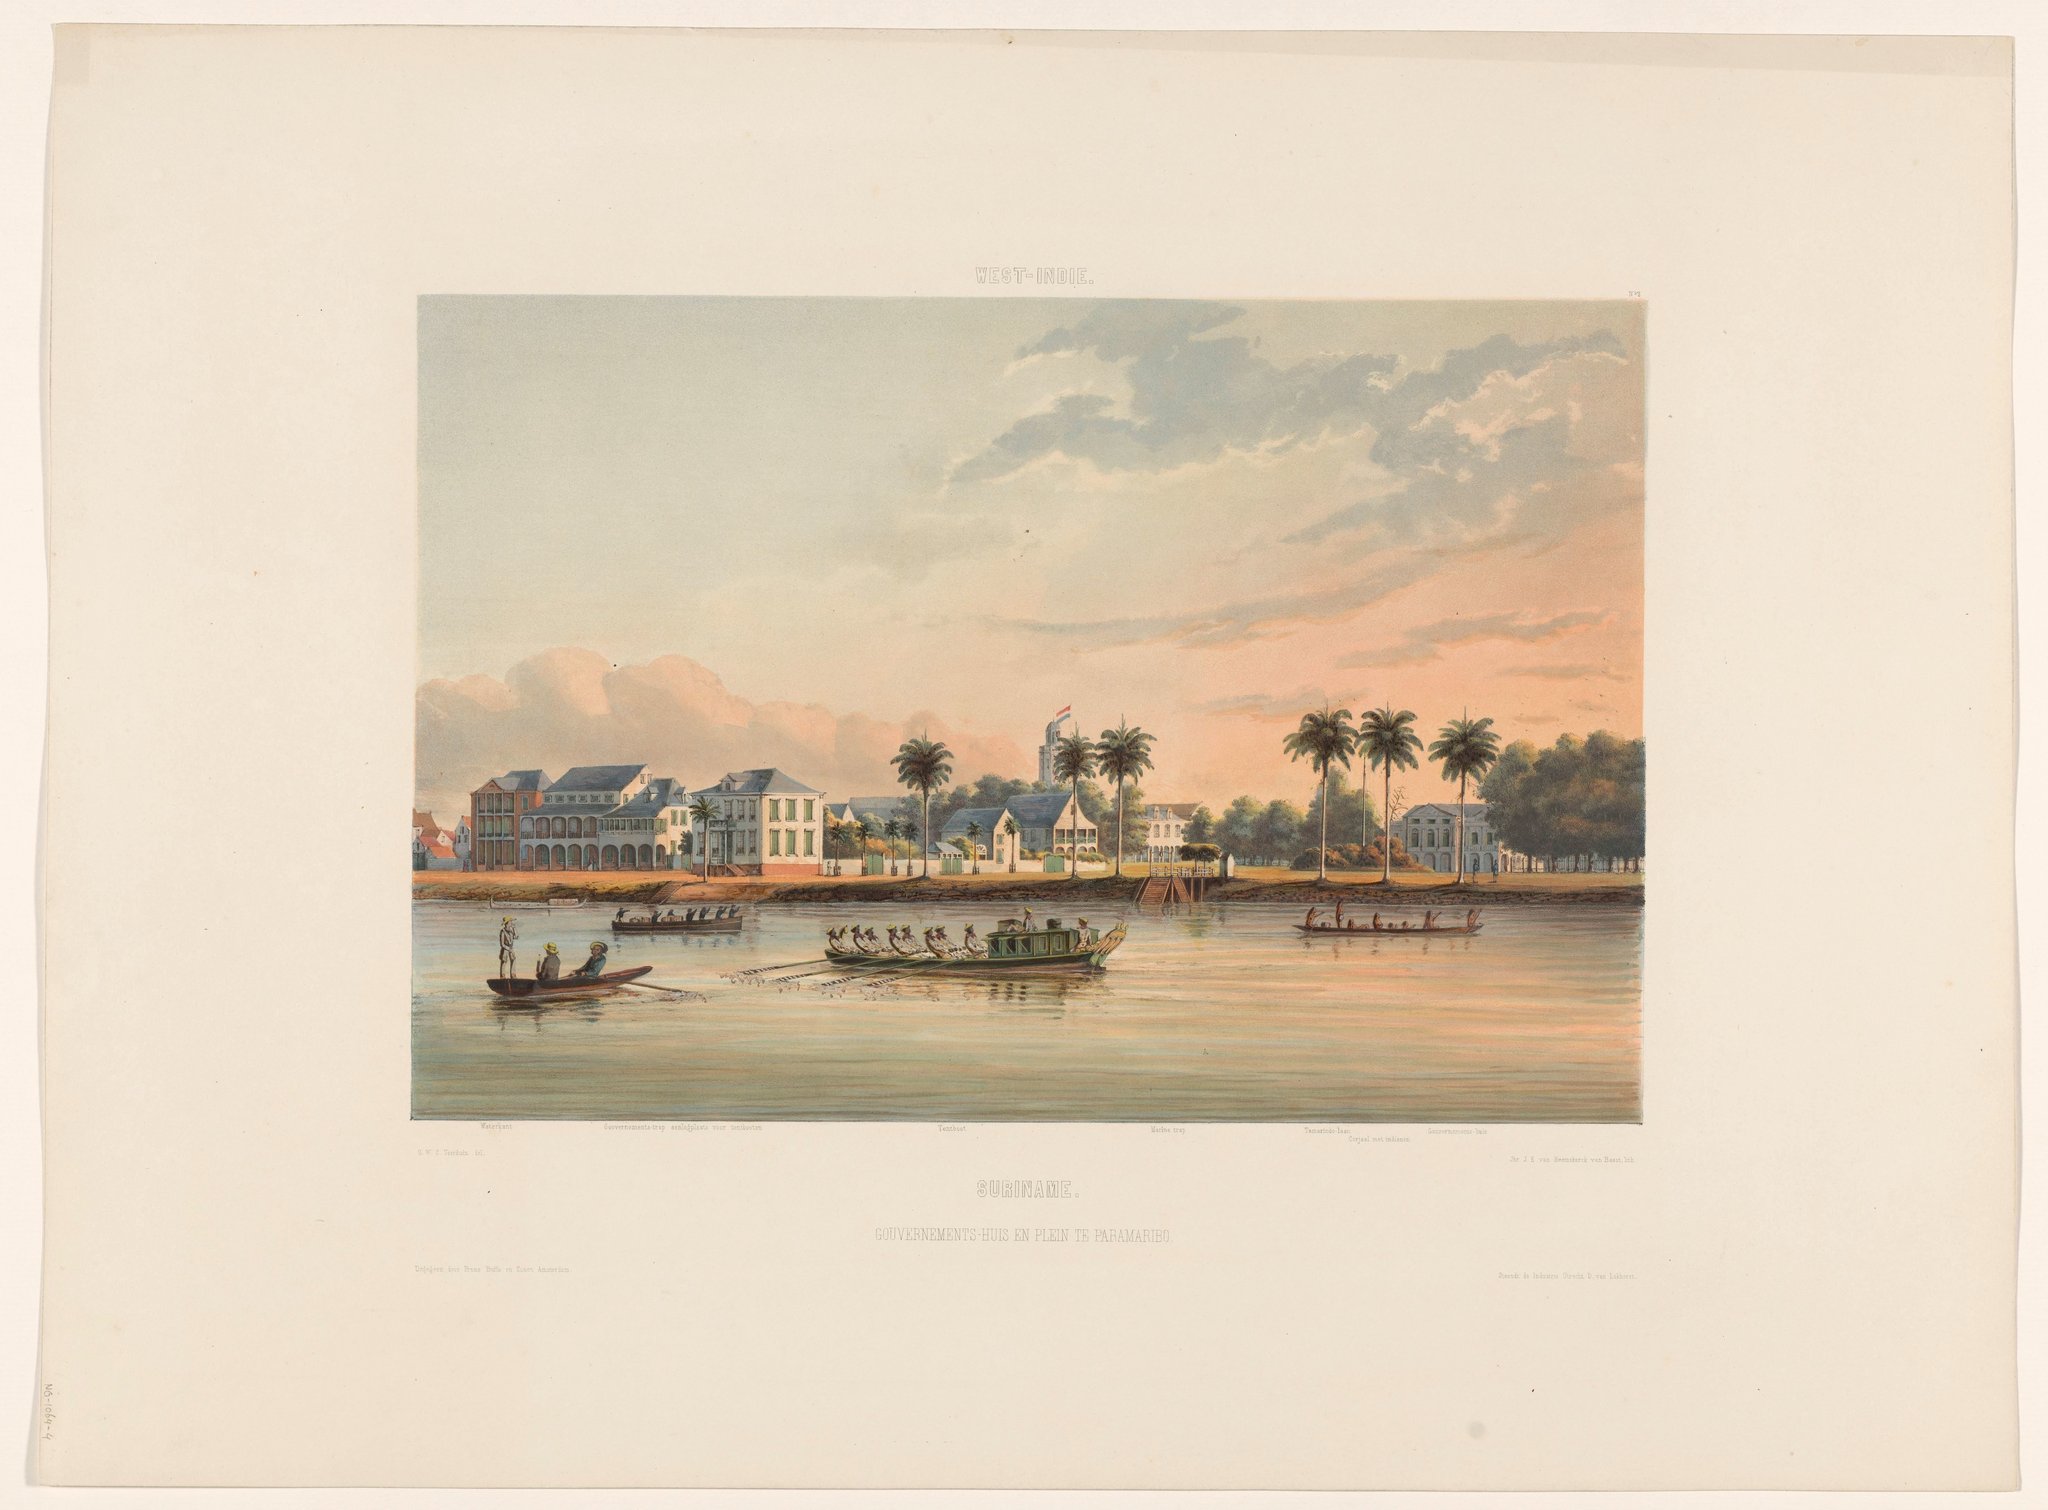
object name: print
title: Suriname. Gouvernements-huis en plein te Paramaribo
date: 1860-1862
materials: paper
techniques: lithograph, hand coloring, lacquer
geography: netherlands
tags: colonial system, prospect of city, town panorama, silhouette of city (+ city(-scape) with figures, staffage), suriname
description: Gezicht vanaf het water op de gouvernementsgebouwen in Paramaribo. Op de plaat staan aangegeven: Waterkant, Gouvernements-trap, Tentboot, Marine trap, Tamarinde-laan, corjaal met indianen en Gouvernements-huis. Onderdeel van het plaatwerk 'Gezigten uit Neerland's West-Indien'.